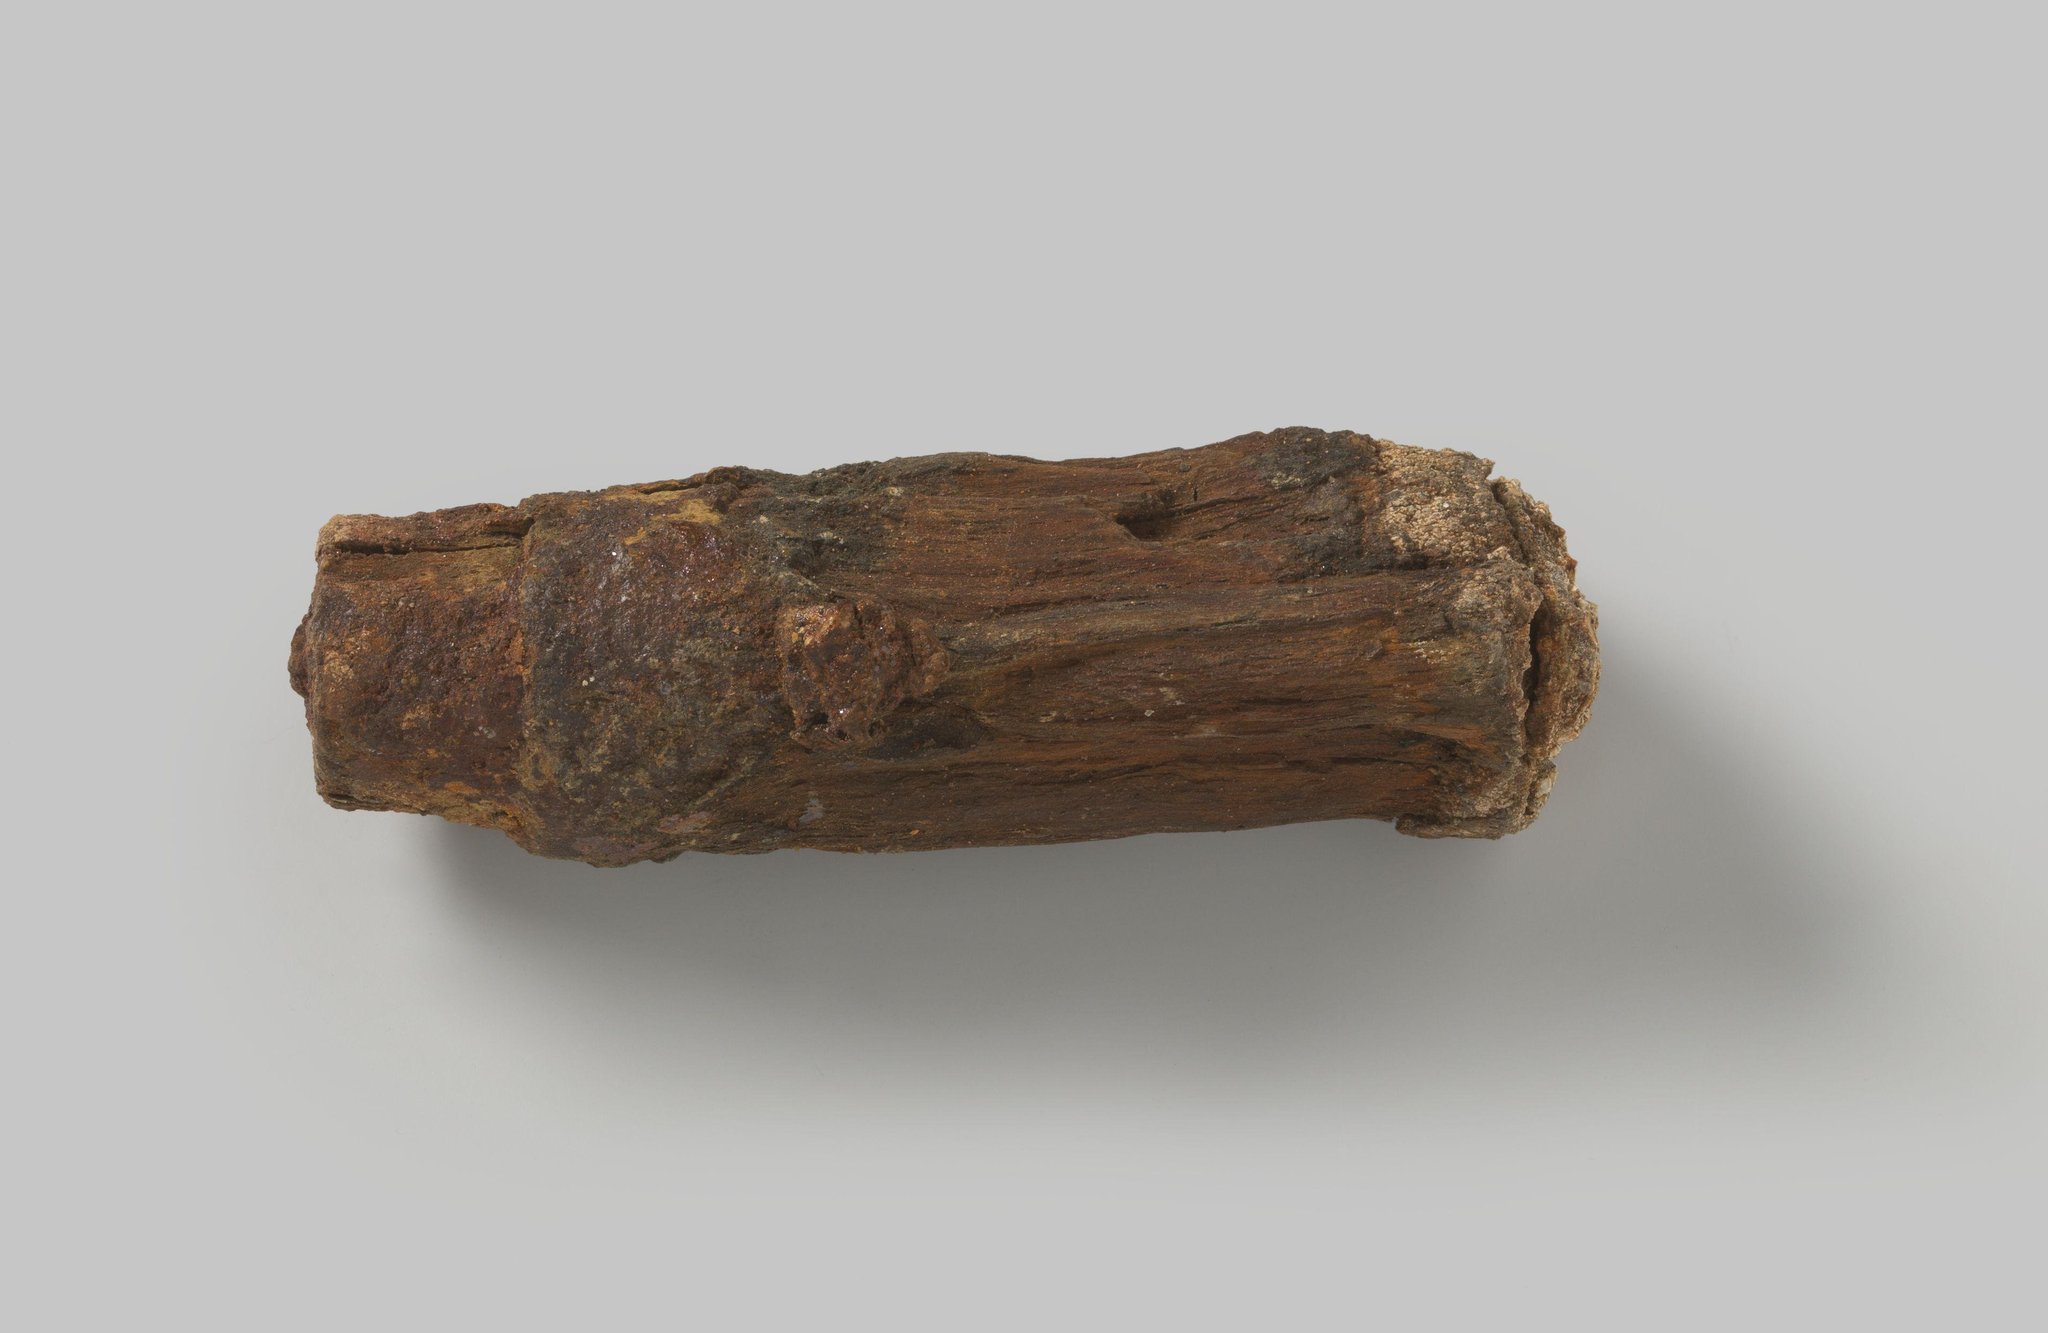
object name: knife handle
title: Messenheft uit het wrak van de Oostindiëvaarder Hollandia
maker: Anonymous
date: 1700-1743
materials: metal, wood